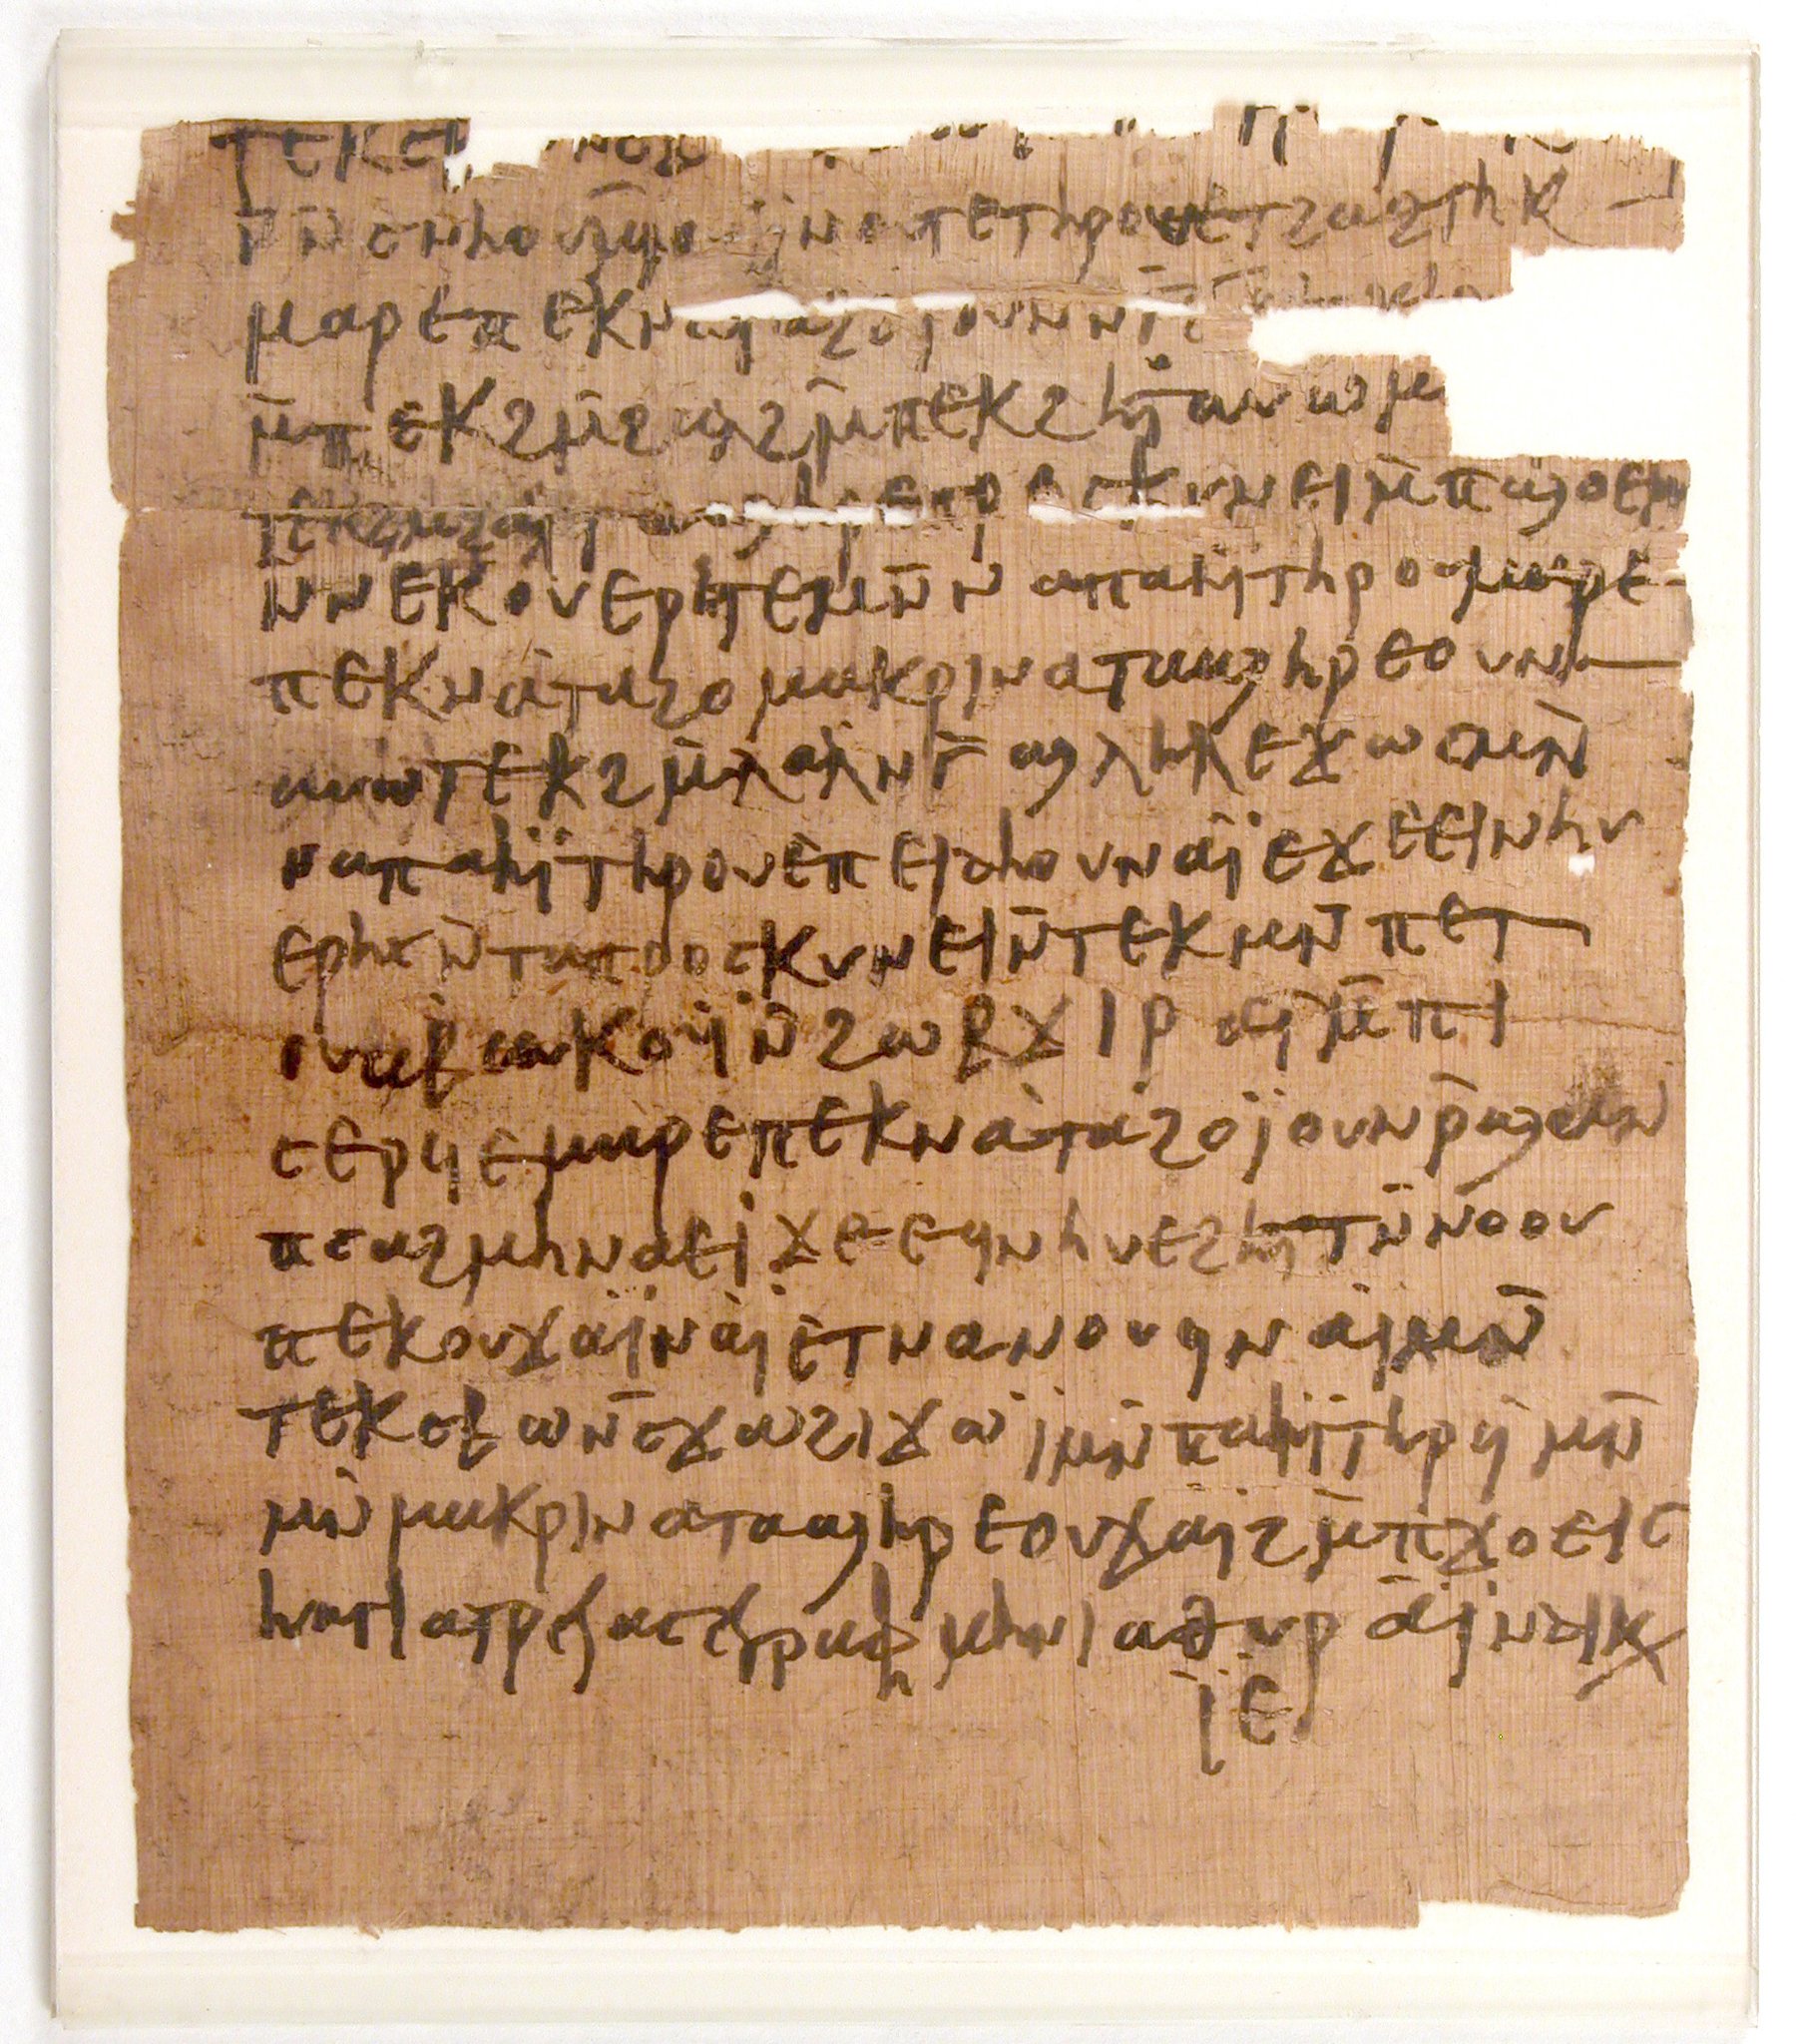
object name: fragment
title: Papyrus Fragment of a Letter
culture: coptic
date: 580-640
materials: ink, papyrus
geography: egypt